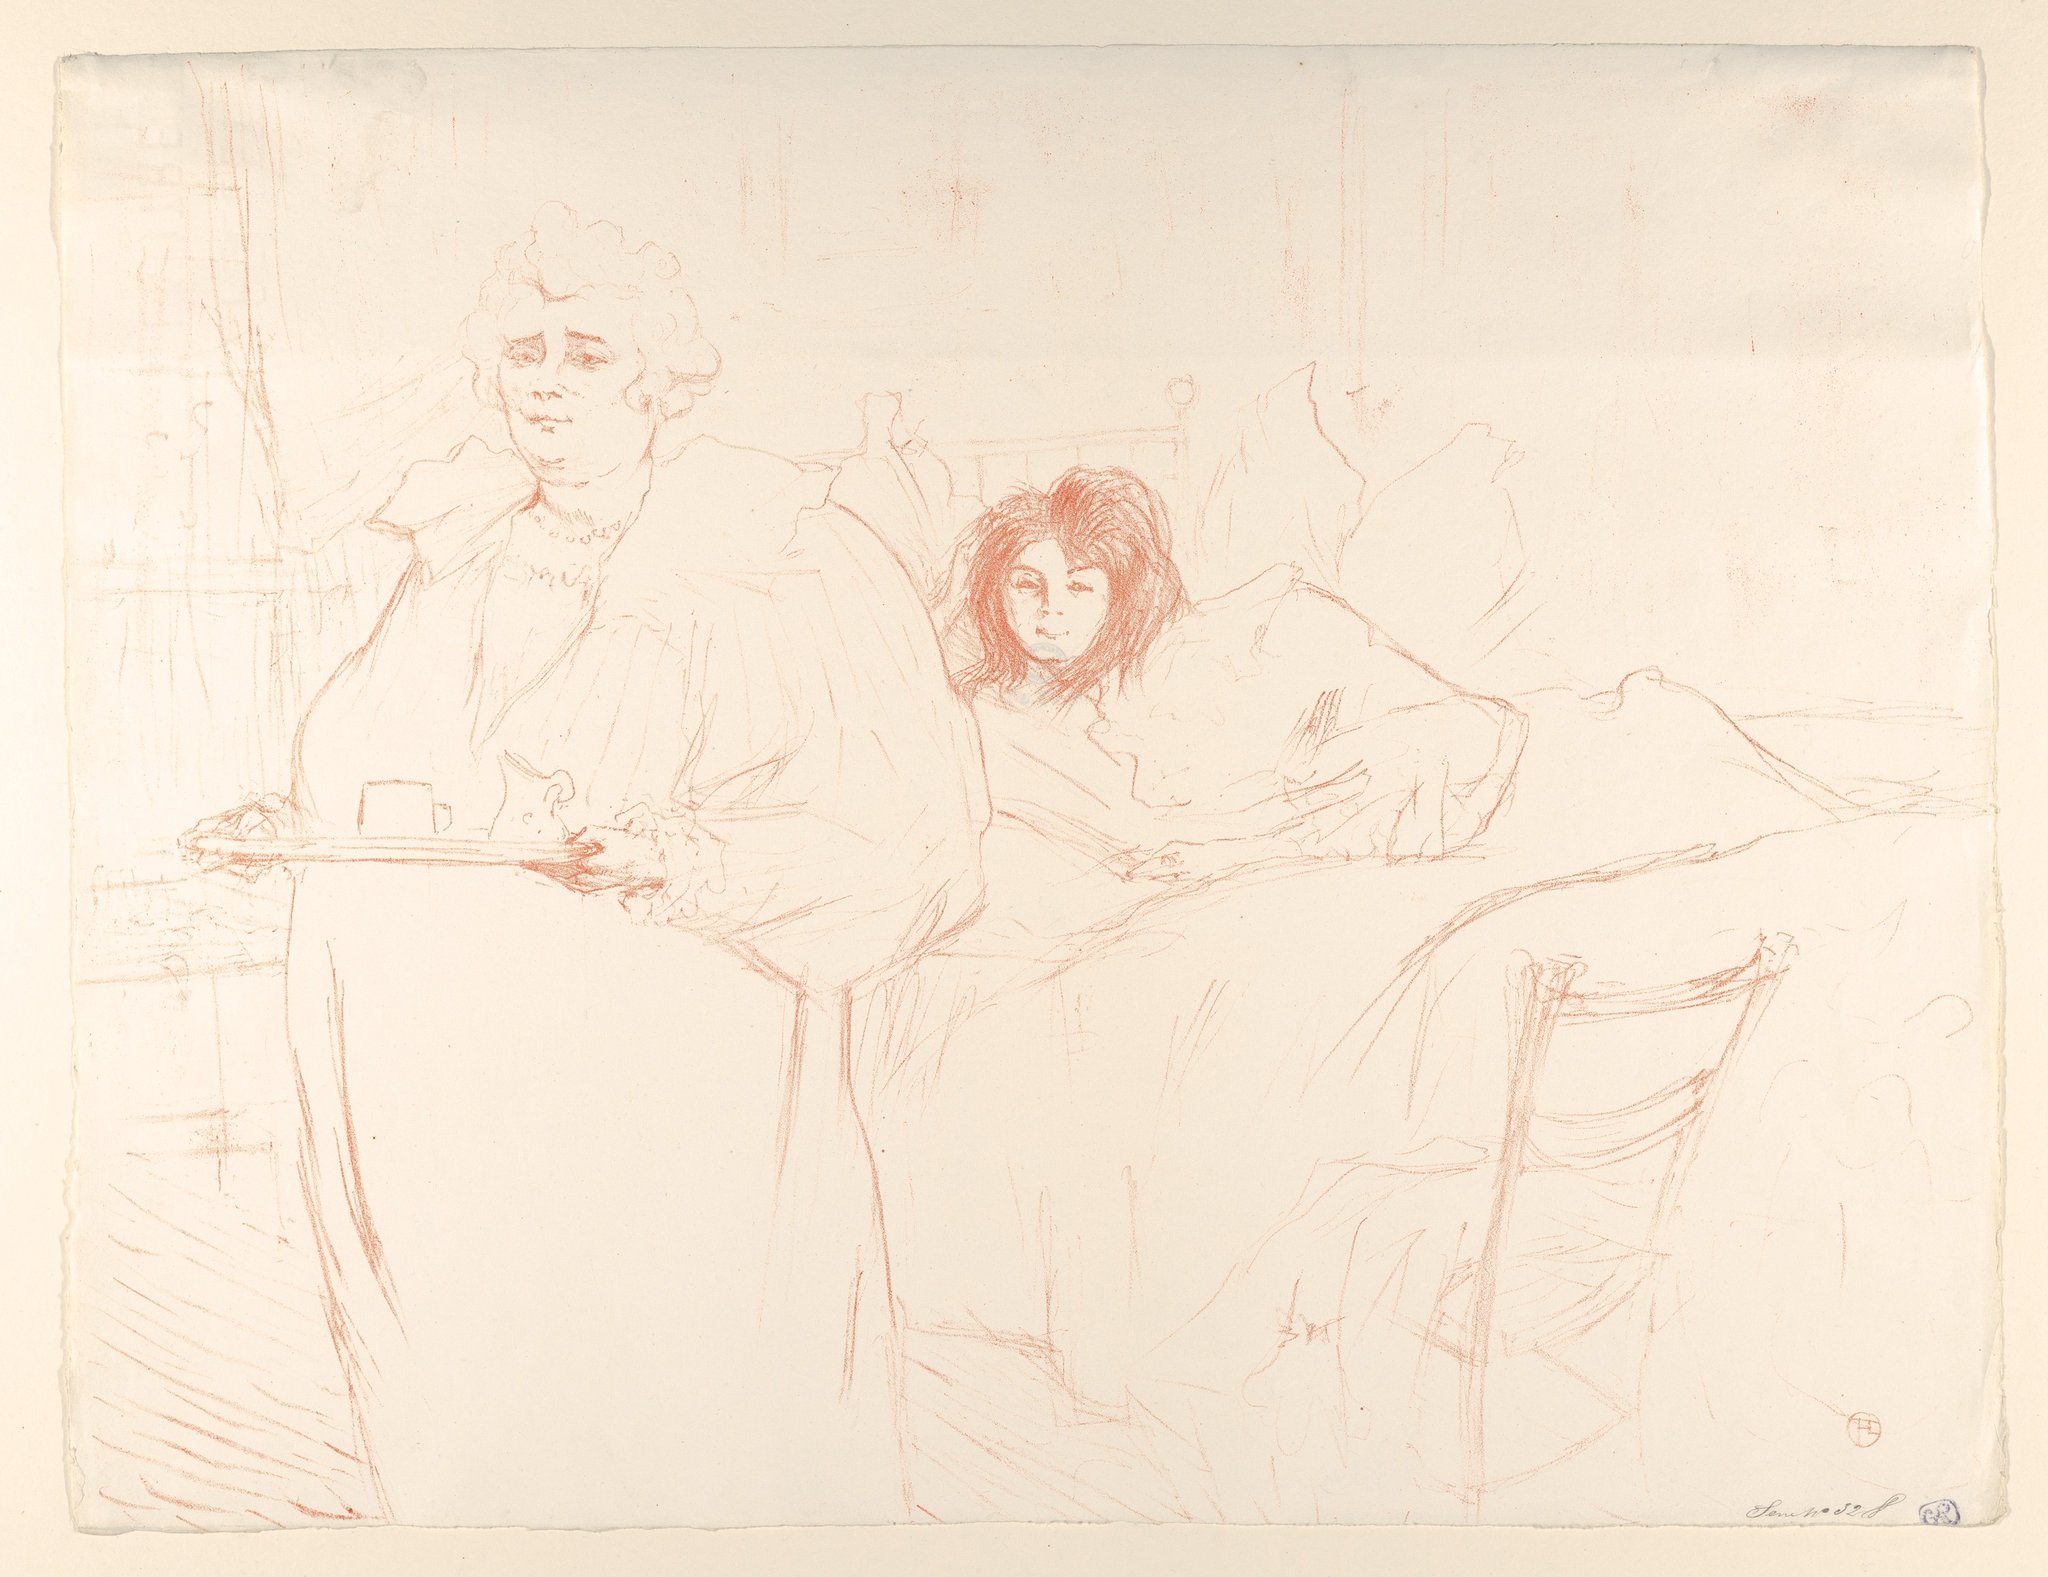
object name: print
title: Serving Breakfast (Madame Baron and Mademoiselle Popo), from "Elles"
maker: henri de toulouse-lautrec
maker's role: artist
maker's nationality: french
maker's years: 1864-1901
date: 1896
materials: crayon, paper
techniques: lithograph, printing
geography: france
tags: women